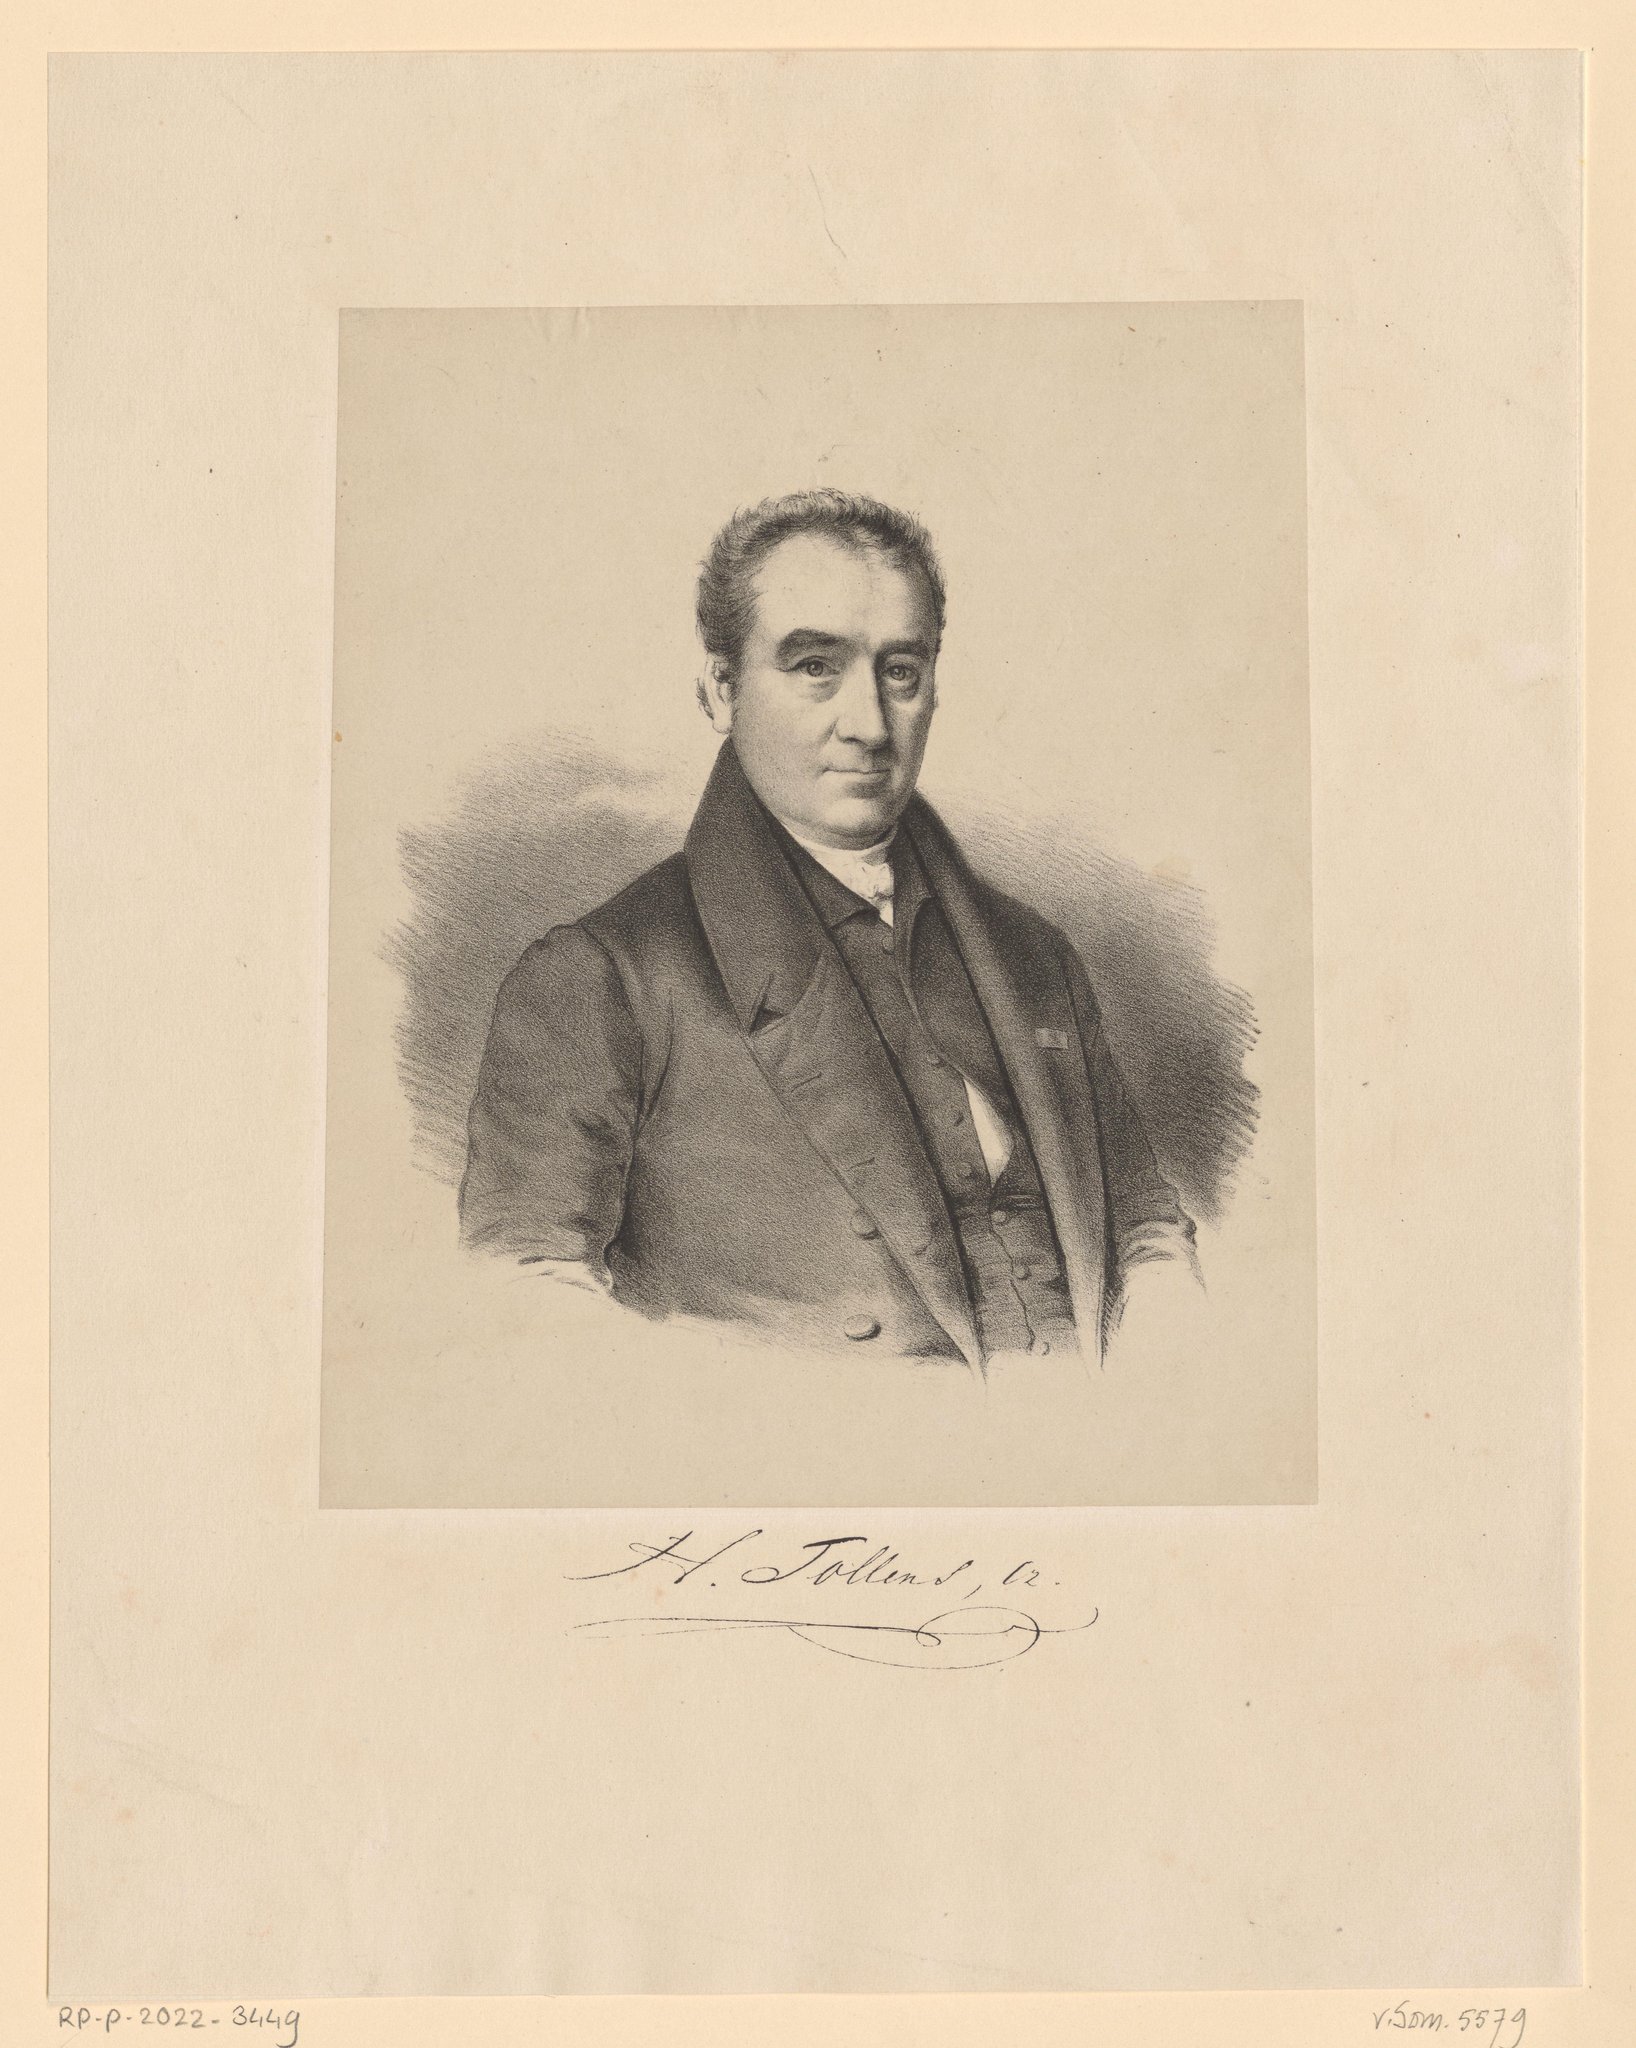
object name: print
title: Portret van Hendrik Tollens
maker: carel frederik curtenius bentinck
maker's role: print maker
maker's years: 1814-1849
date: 1843-1844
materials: paper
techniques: lithograph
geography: netherlands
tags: hendrik tollens, historical persons, portrait of a writer